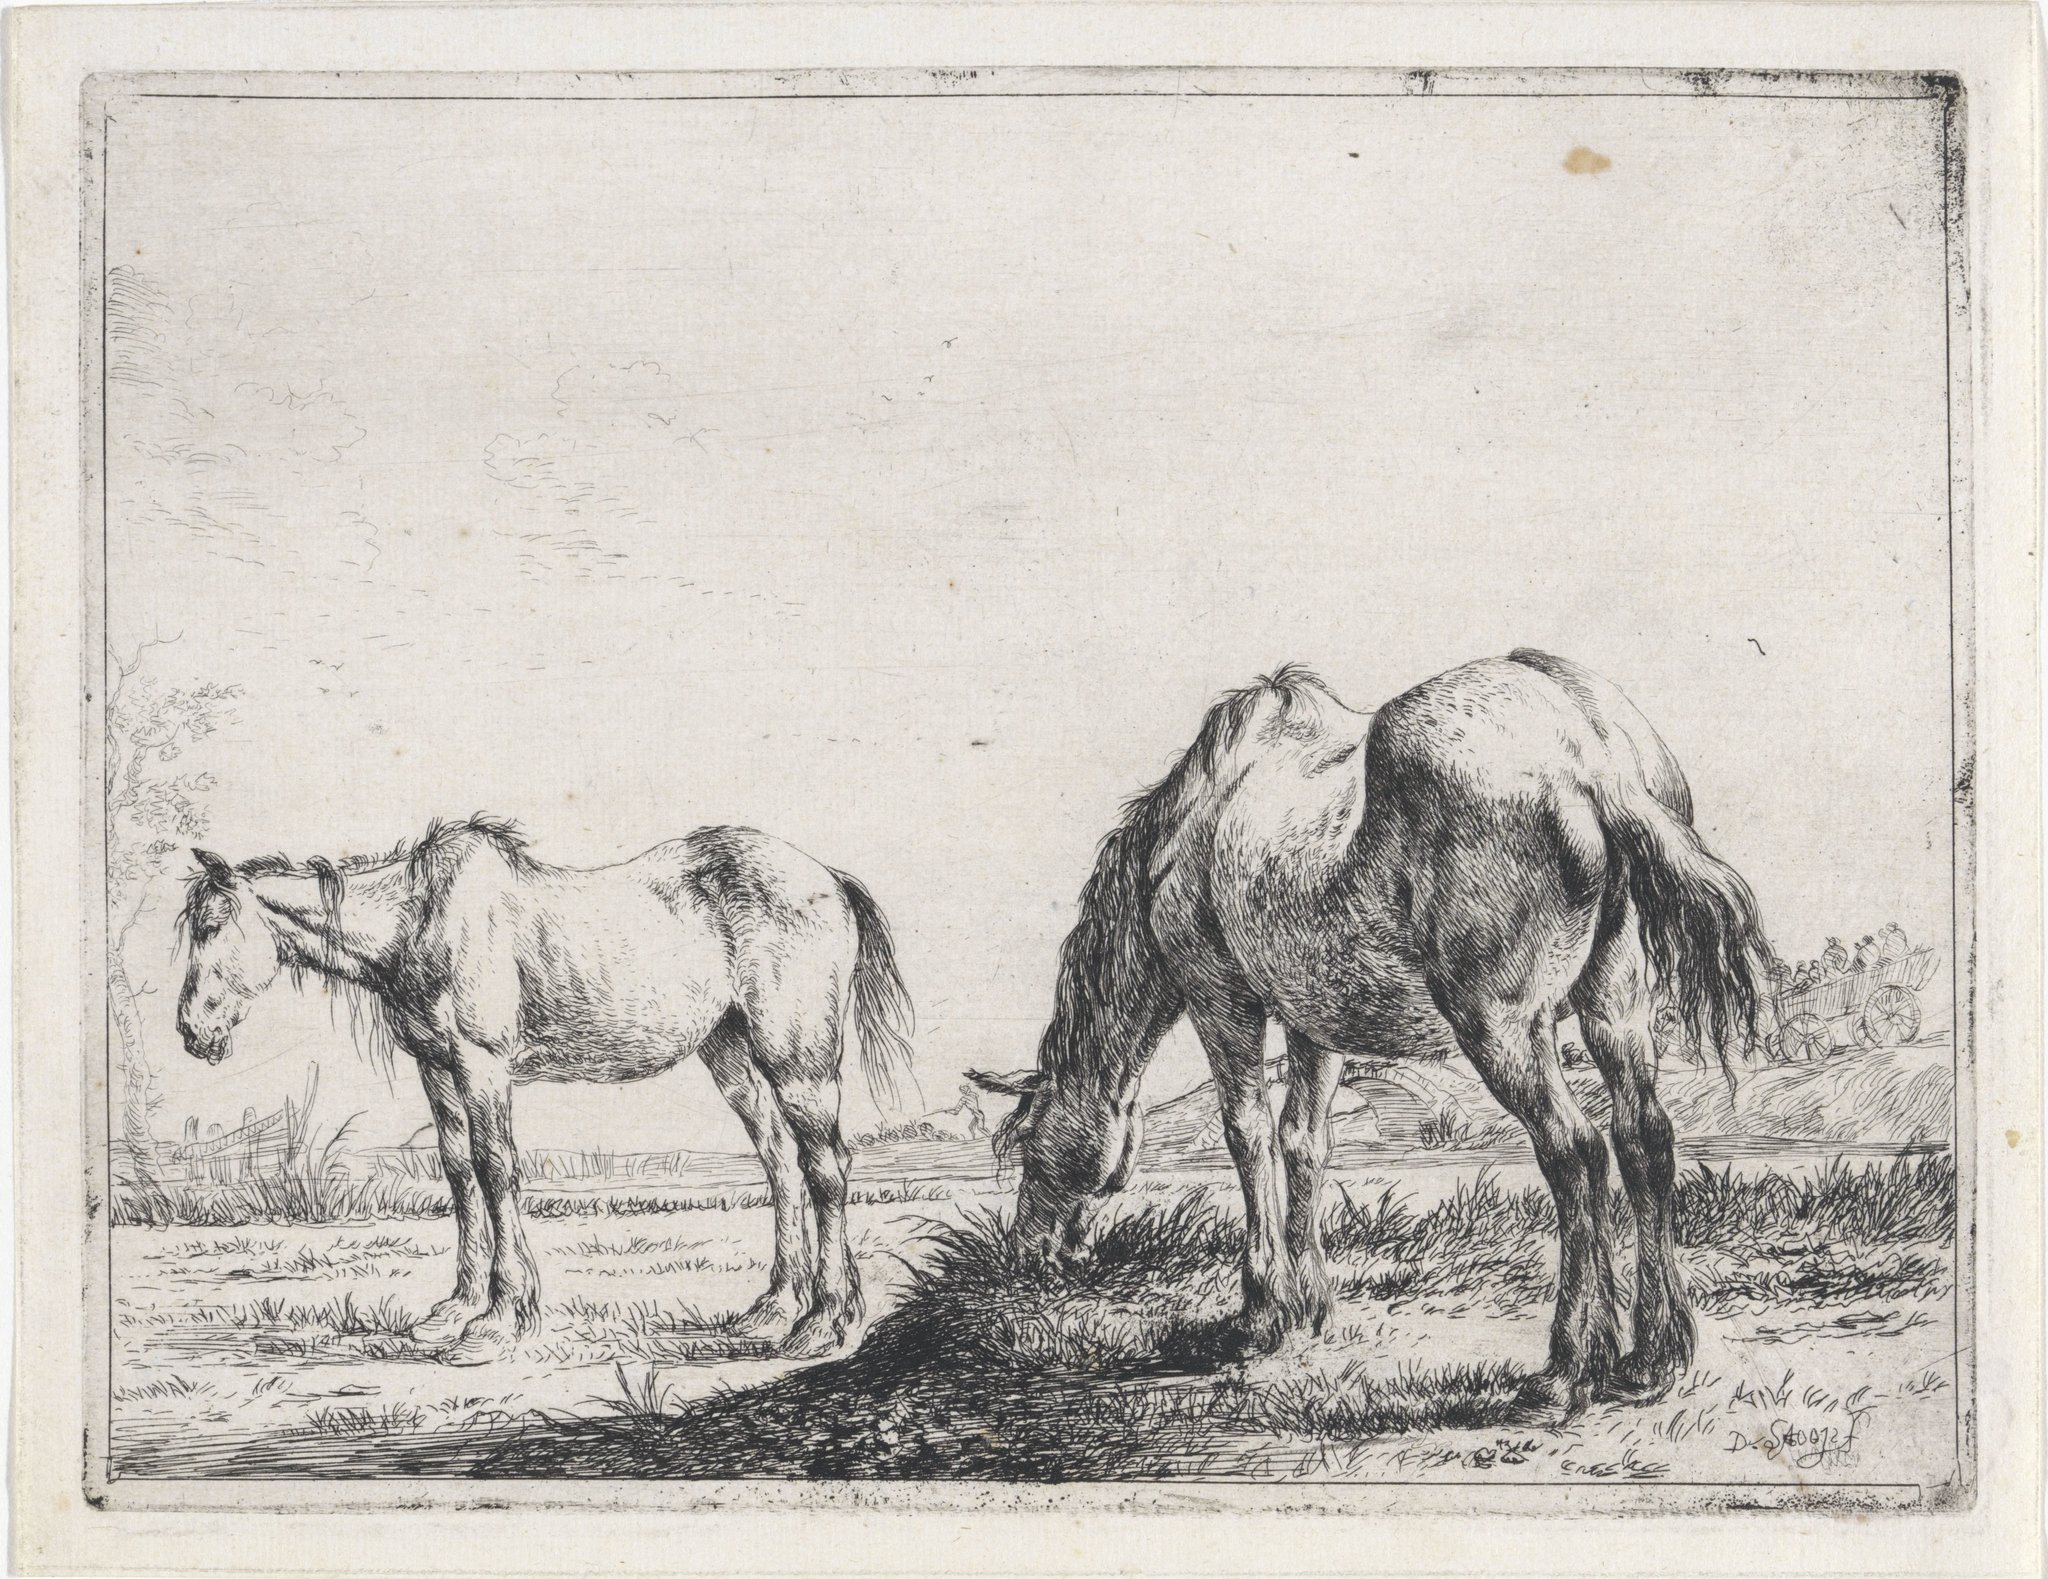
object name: print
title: Paarden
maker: dirk stoop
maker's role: draughtsman, painter, print maker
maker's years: 1615-1686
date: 1651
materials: paper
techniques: etching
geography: utrecht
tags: horse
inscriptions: collector's mark: Lugt 2228, collector's mark: Lugt 240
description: Twee paarden in een landschap. Het paard rechts graast.